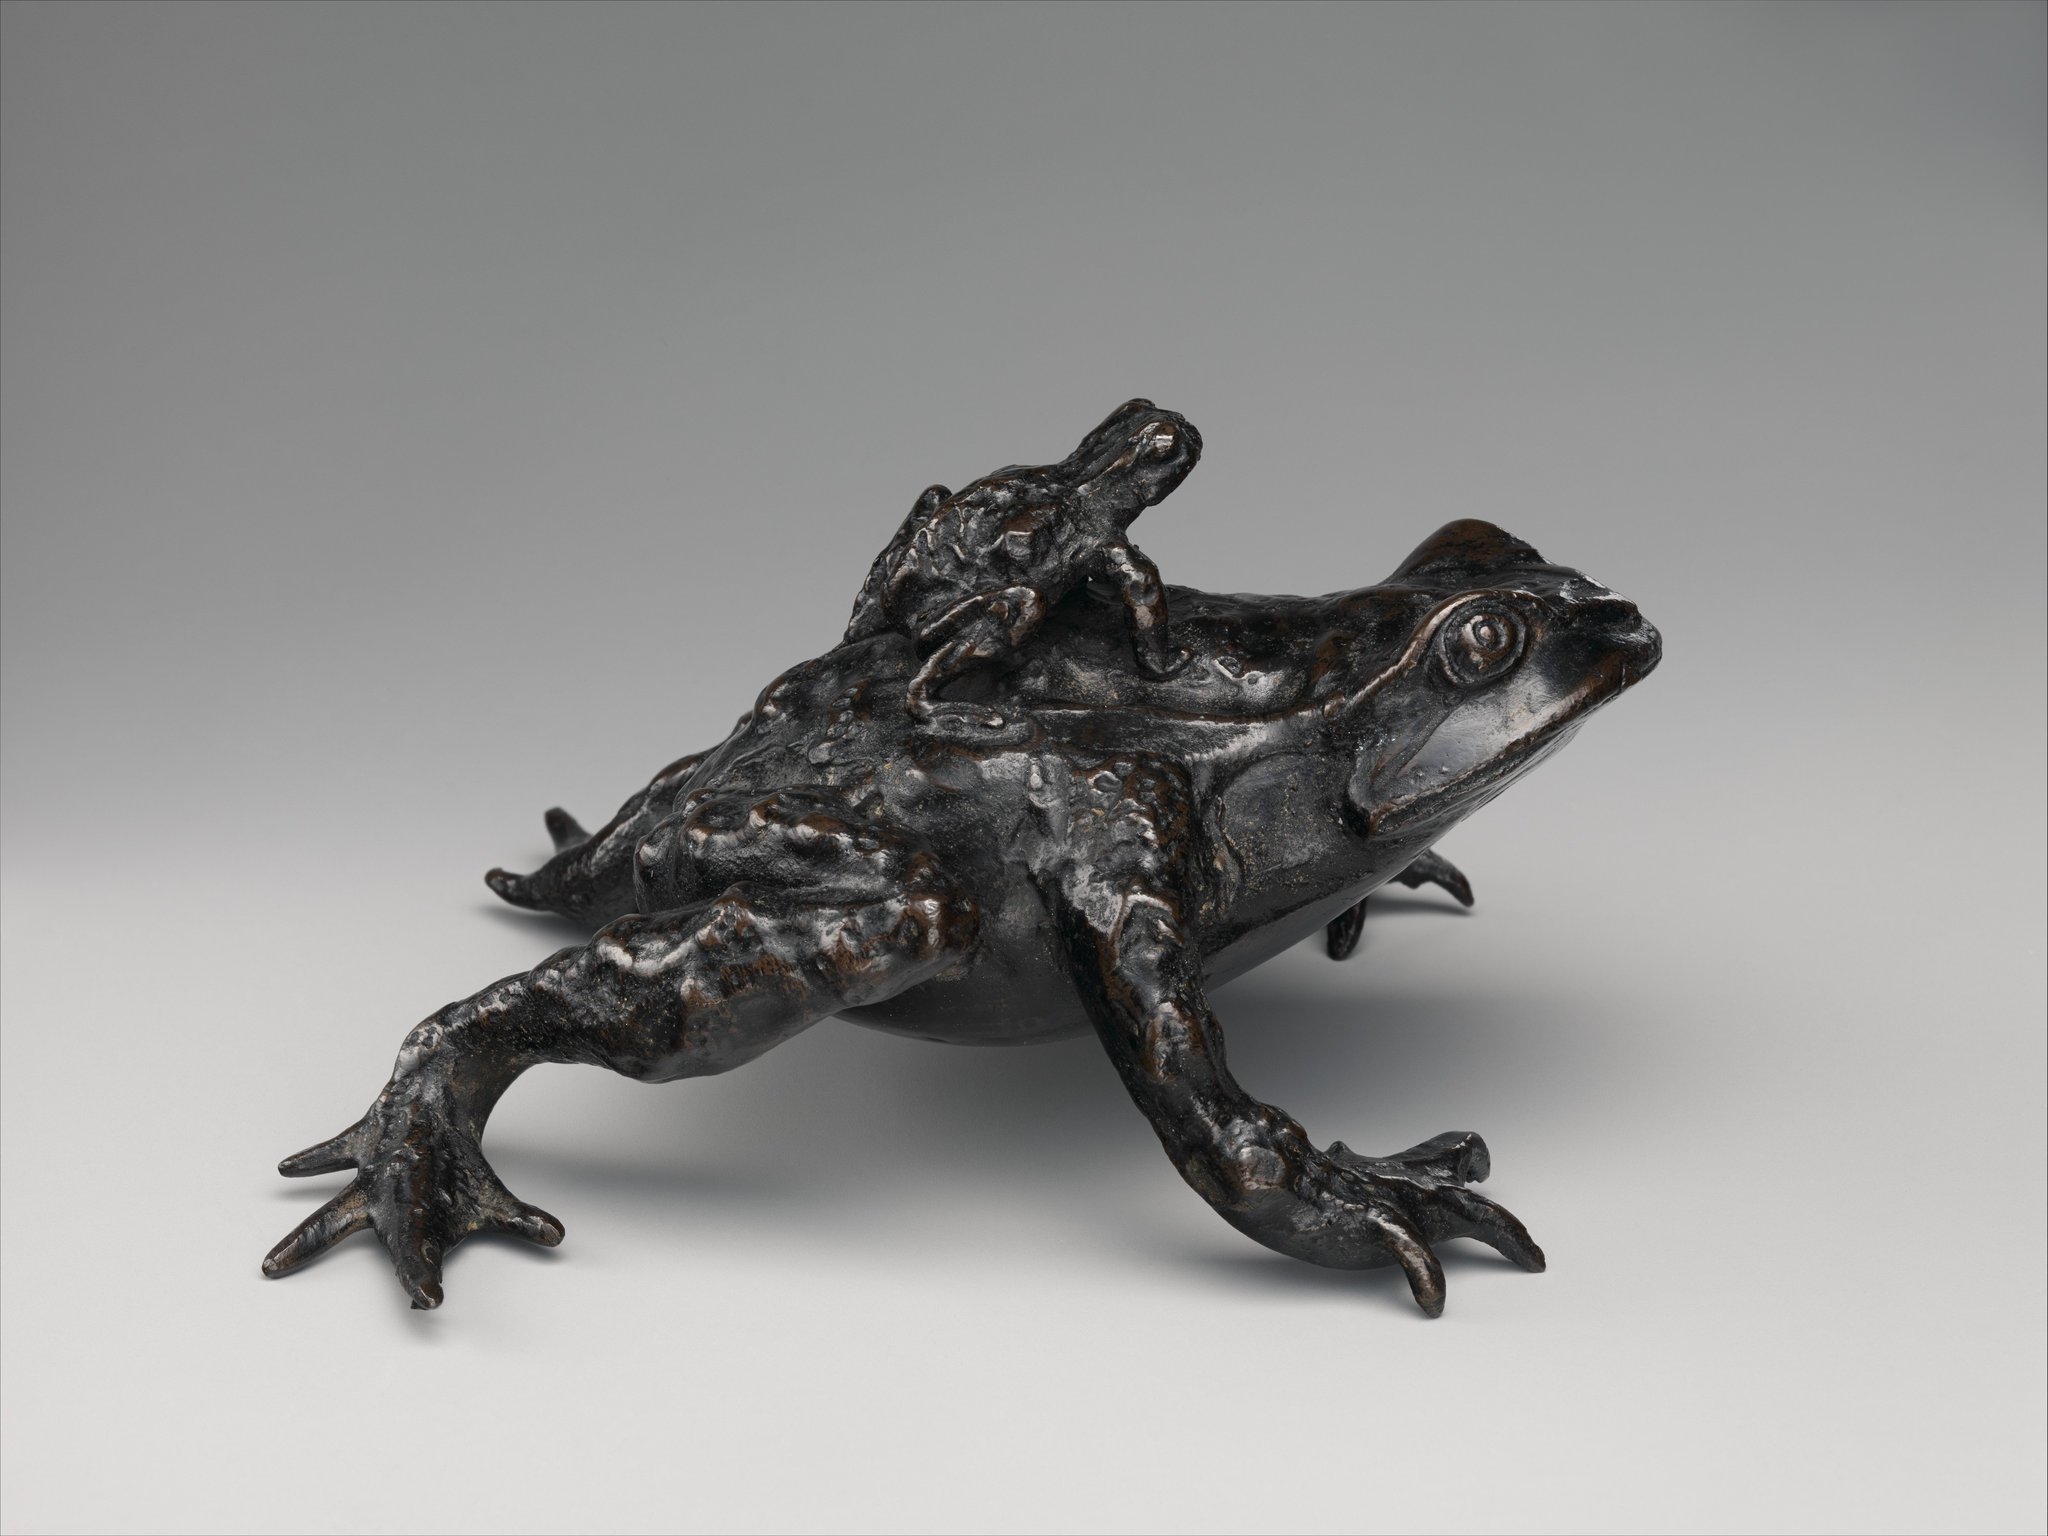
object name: statuette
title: Toad with a Young Toad on its Back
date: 1501-1600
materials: bronze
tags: frogs